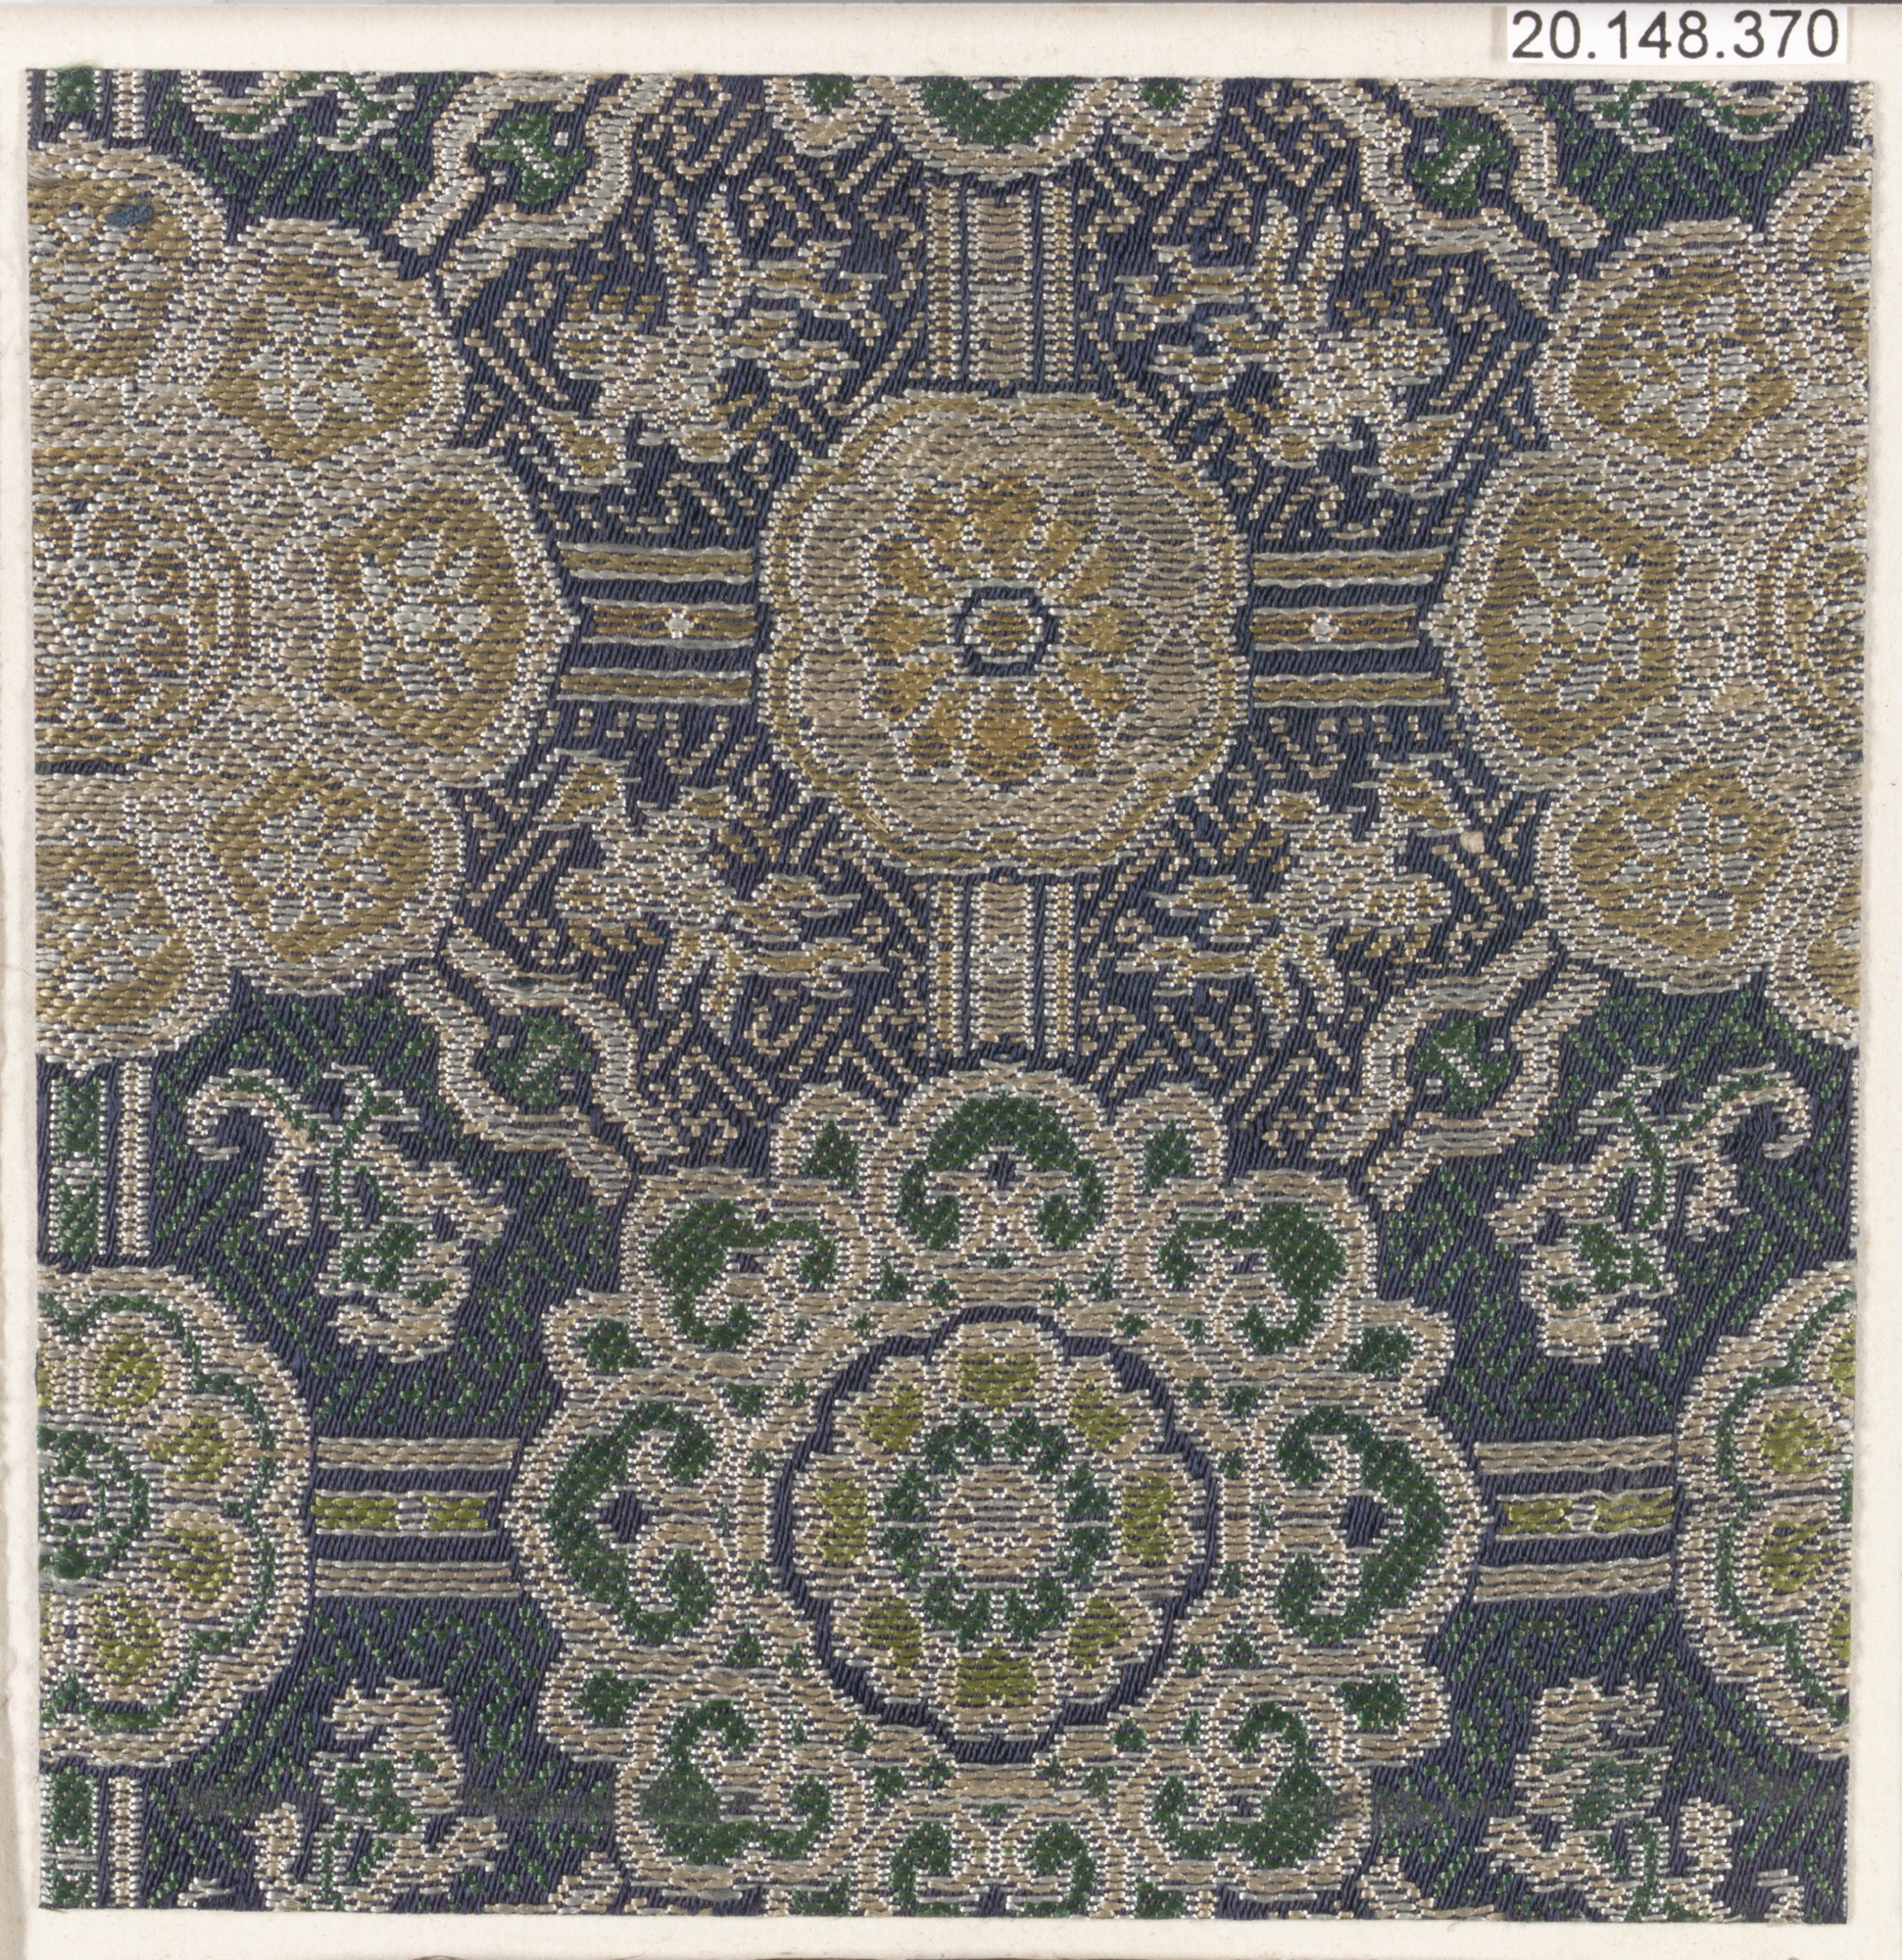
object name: piece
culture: japanese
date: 1701-1800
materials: silk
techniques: compound weave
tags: flowers